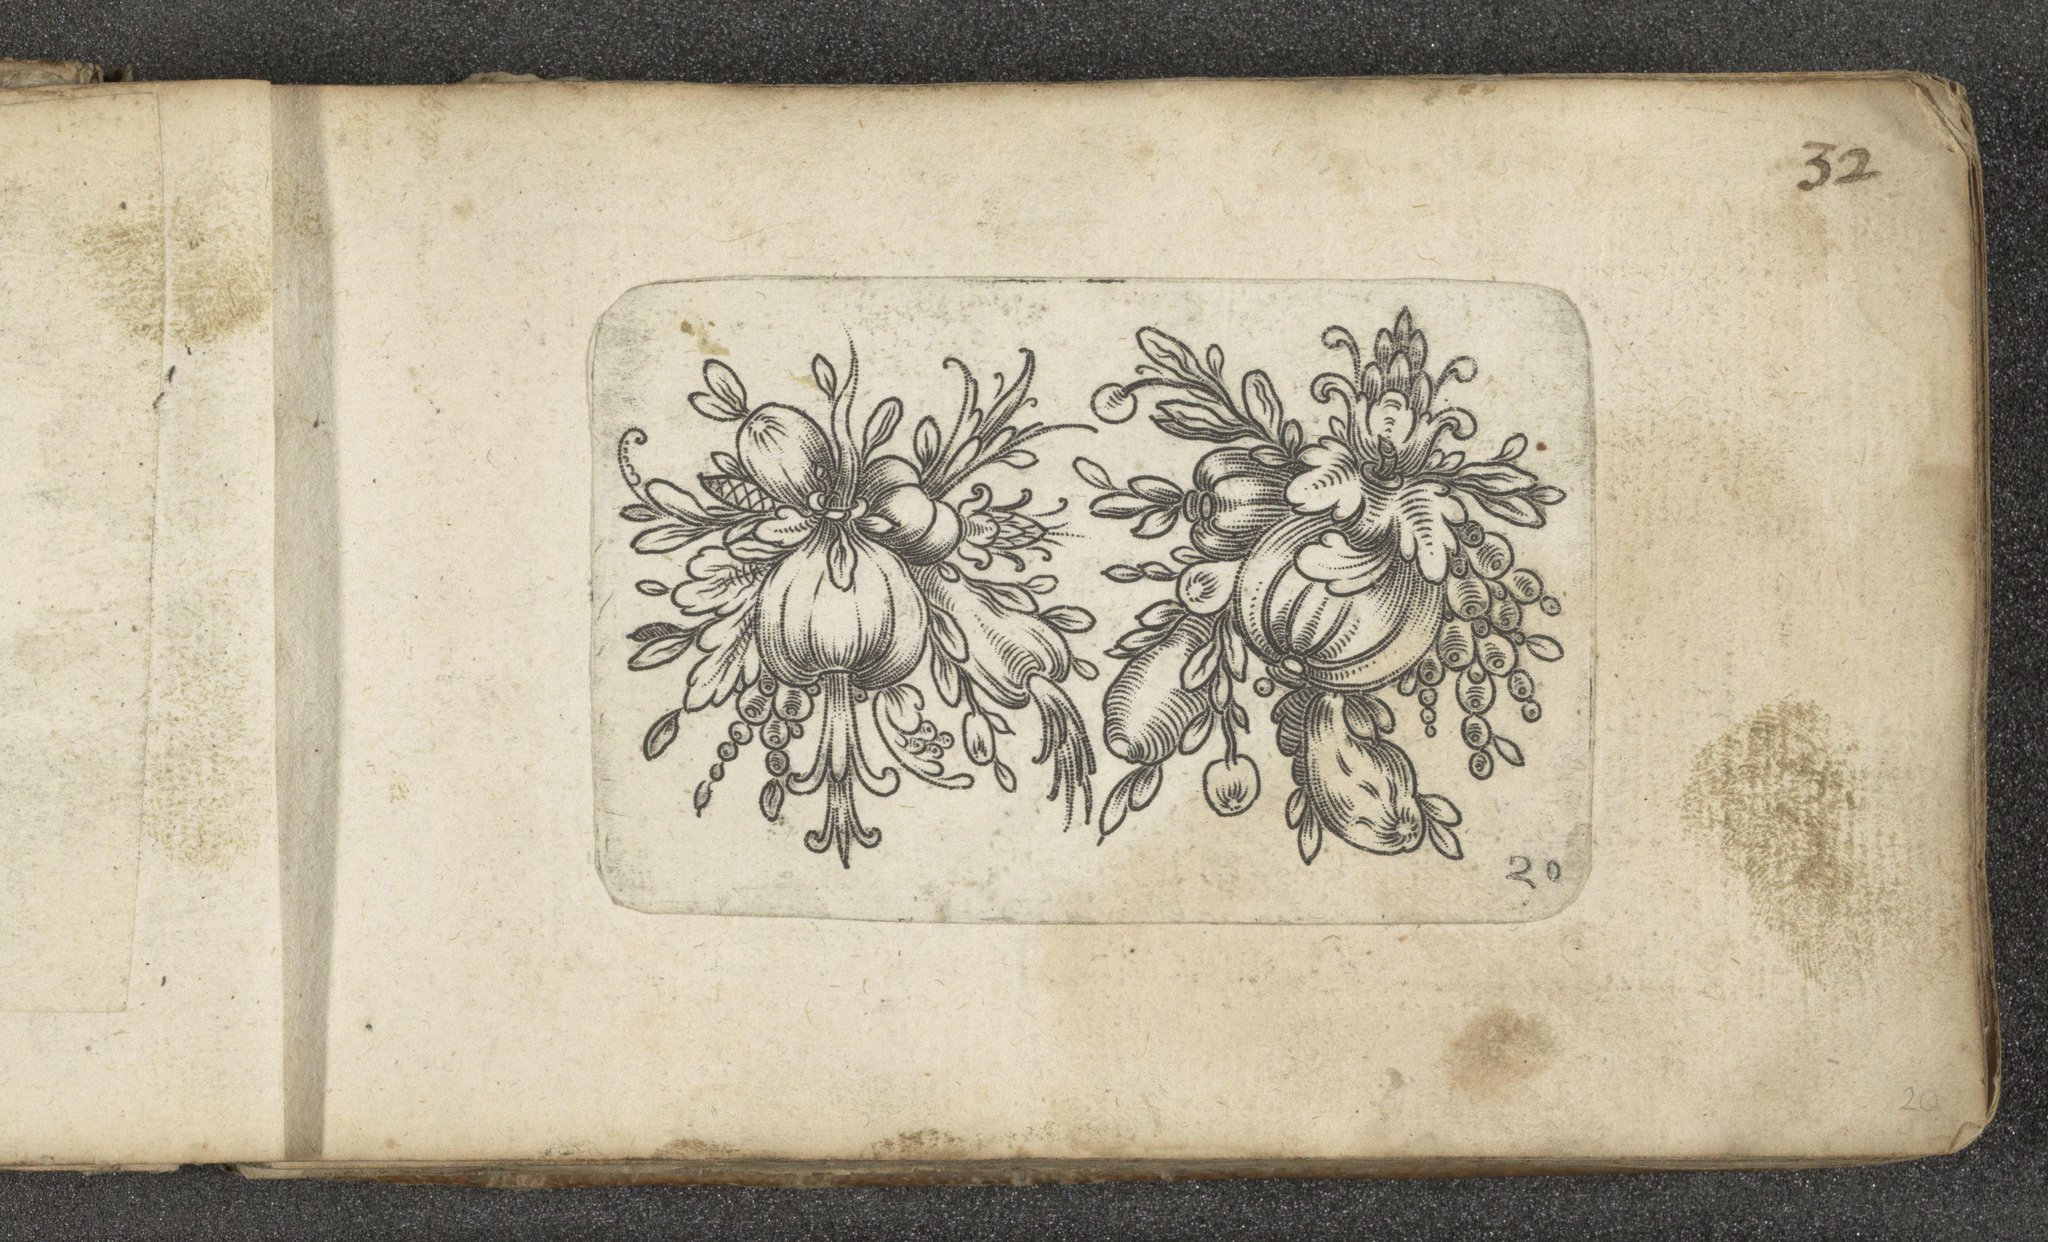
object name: ornament print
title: Ornamenten met cherubijnen en trossen fruit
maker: Anonymous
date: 1601-1650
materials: paper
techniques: etching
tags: ornaments ~ art, fruits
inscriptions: inscription: ‘32’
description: Twee trossen fruit. Rechtsonder genummerd: 20. De prent maakt deel uit van een album.